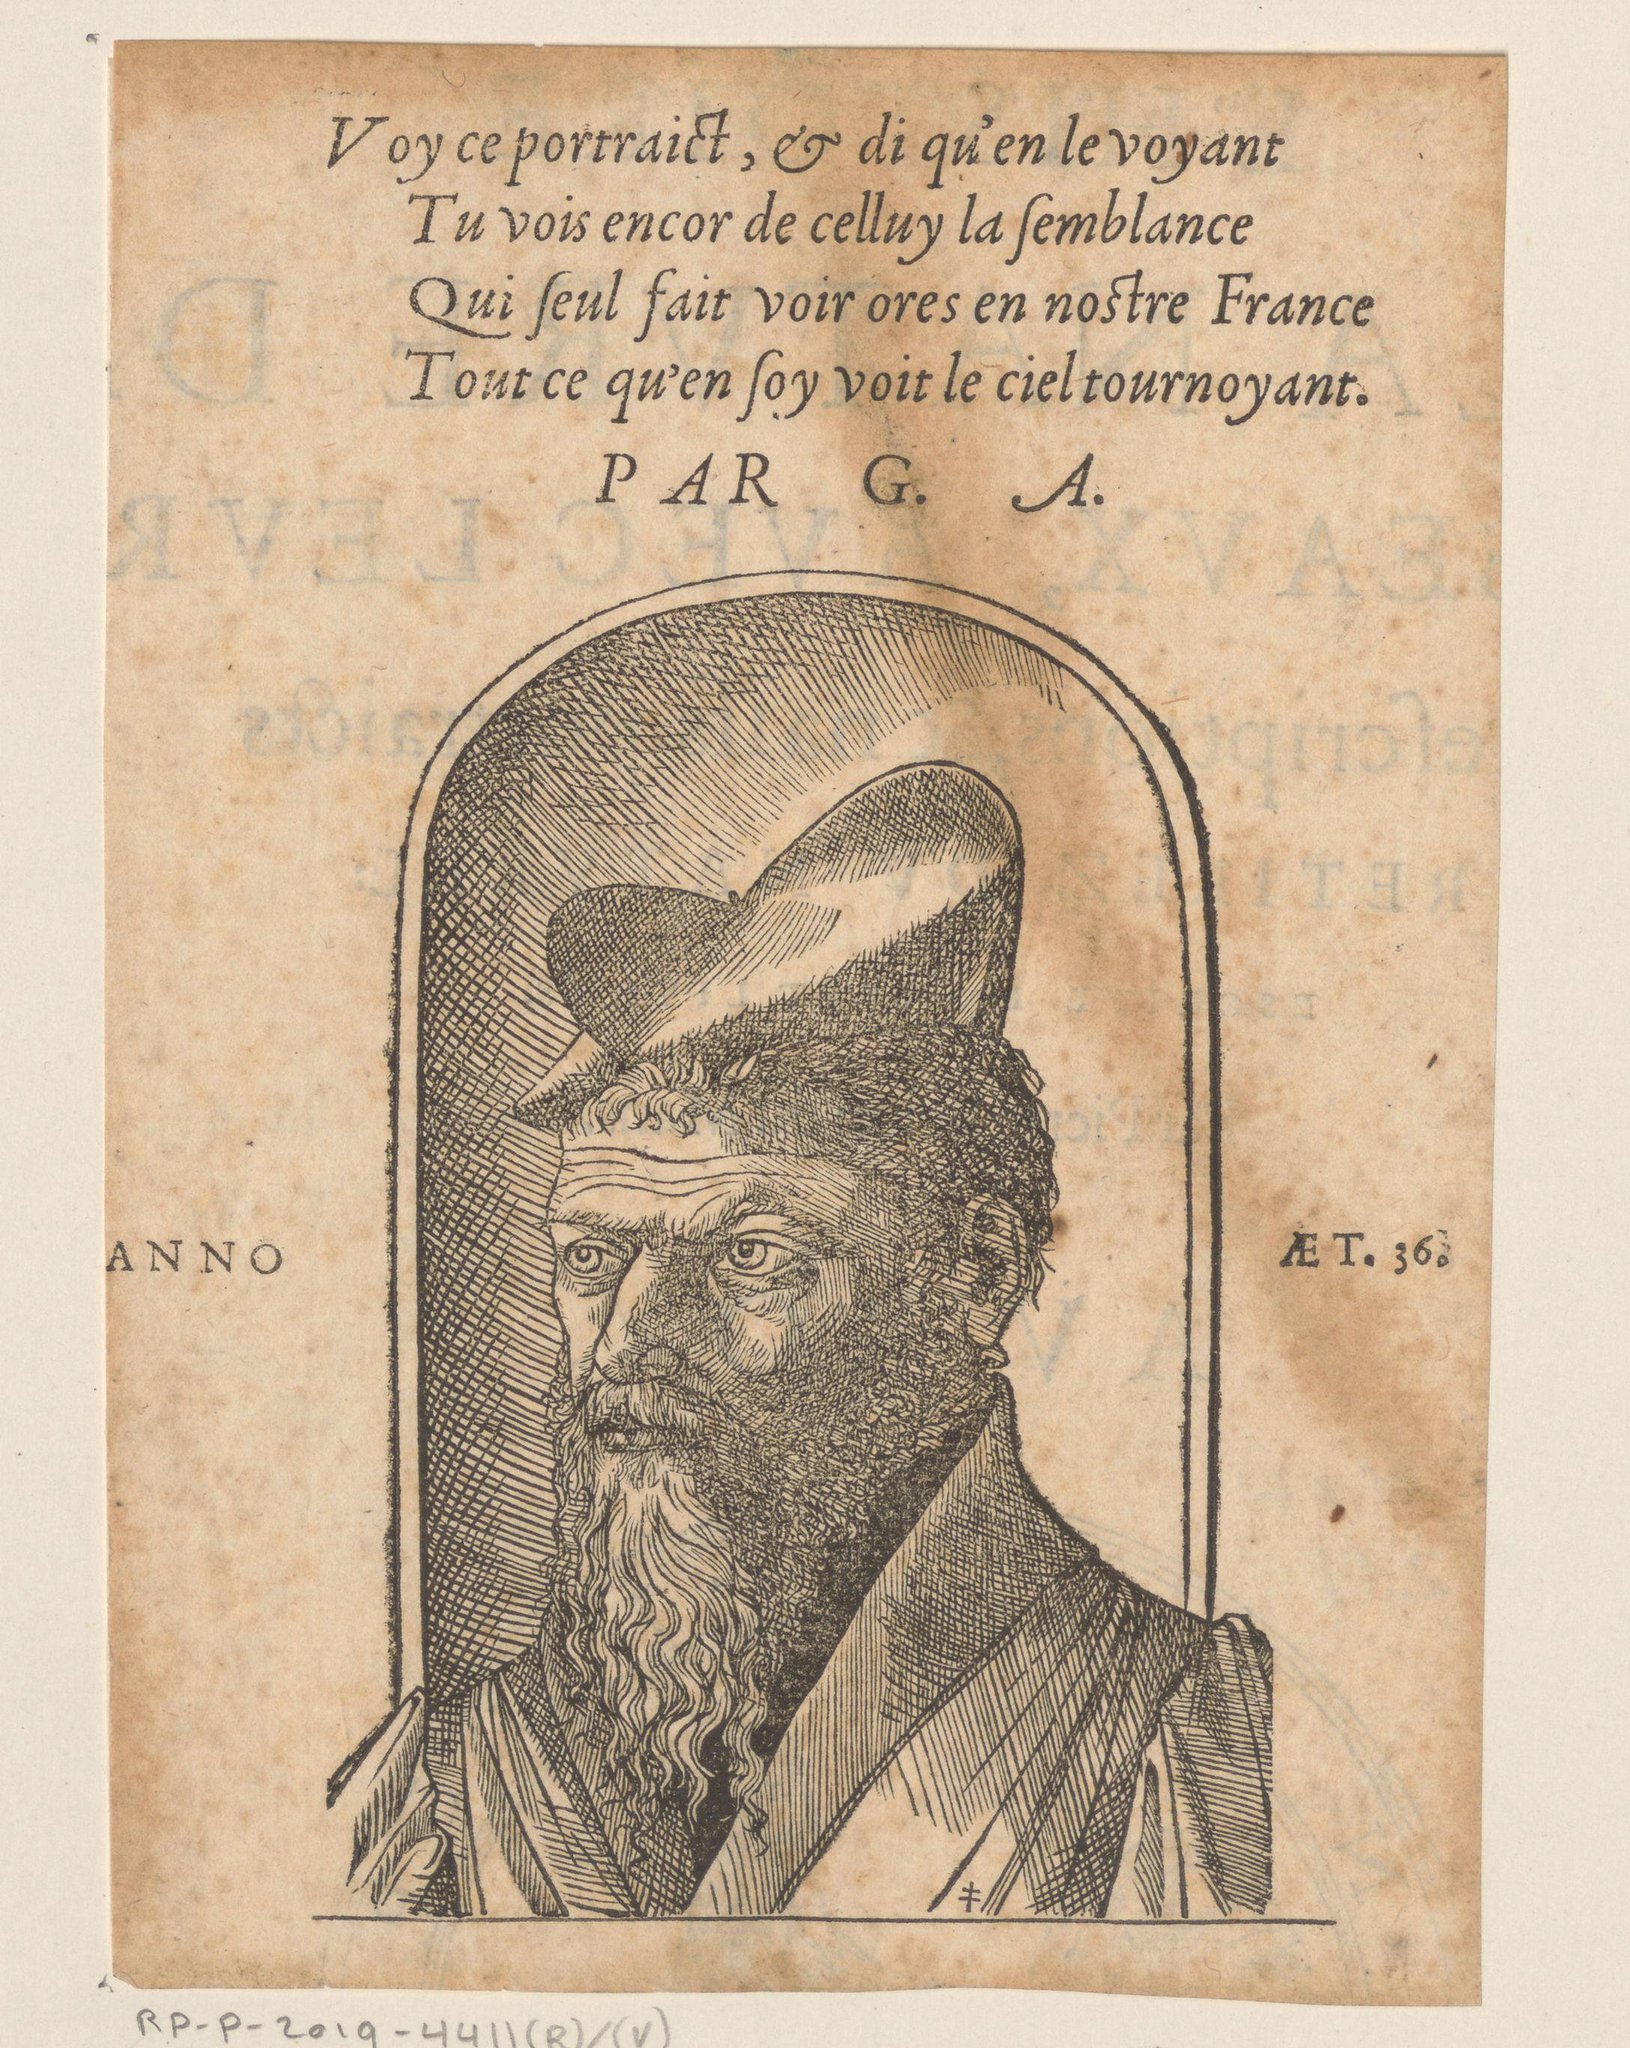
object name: book illustration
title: Portret van Pierre Belon op 36-jarige leeftijd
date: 1555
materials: paper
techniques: letterpress printing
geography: paris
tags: physicist, historical persons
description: Prent uit: Belon, Pierre. L'histoire de la nature des oyseaux, avec leurs descriptions, & naïfs portraicts retirez du naturel (...). Parijs: Guillaume Cavellat, 1555.